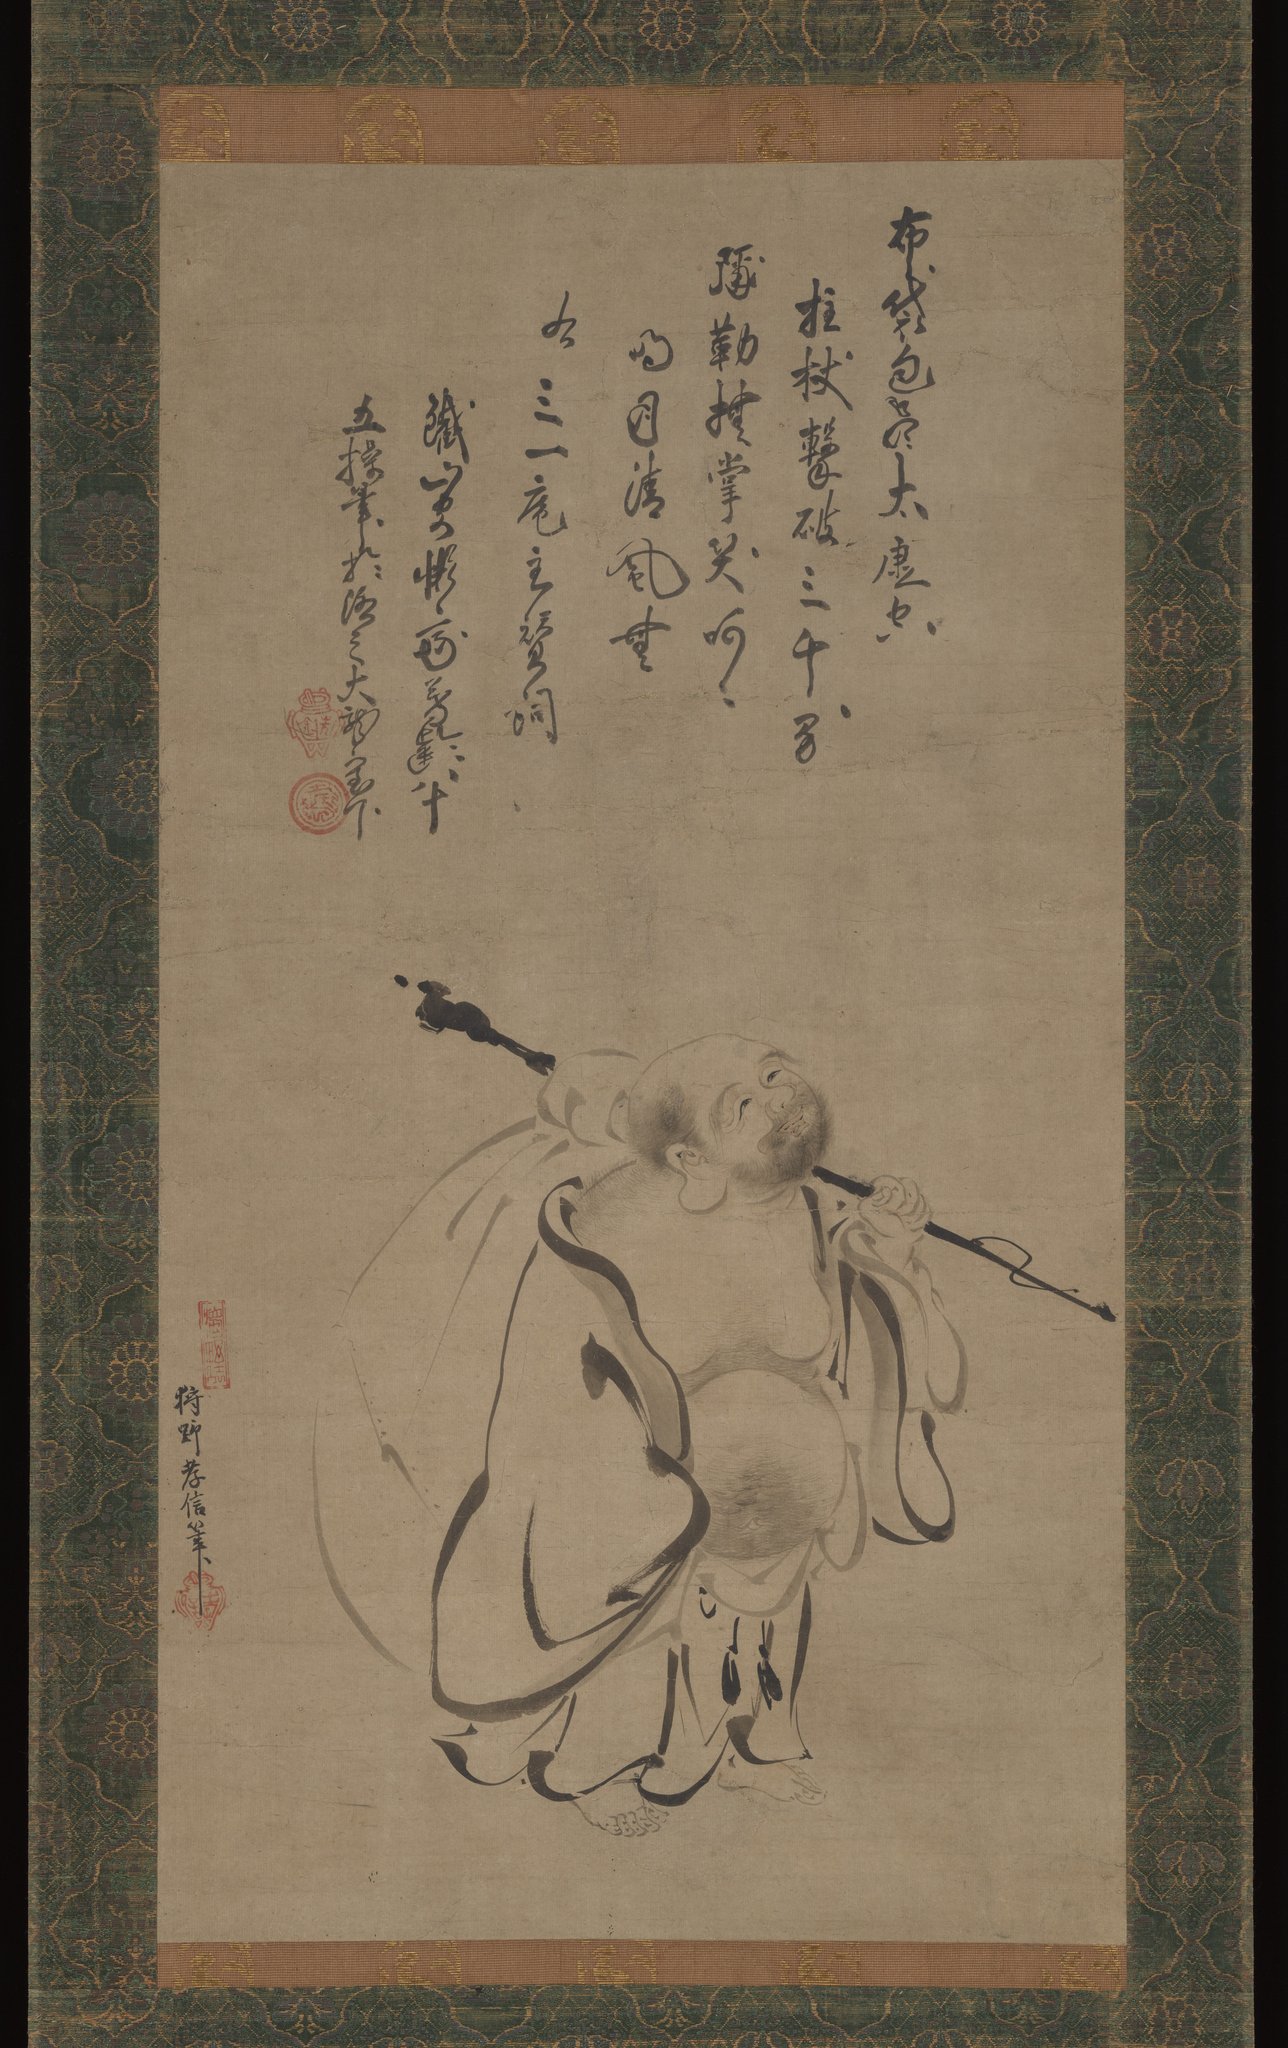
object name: hanging scroll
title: Hotei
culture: japanese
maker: kano takanobu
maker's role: artist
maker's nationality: japanese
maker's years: 1571-1618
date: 1616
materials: ink, paper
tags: men,buddhism